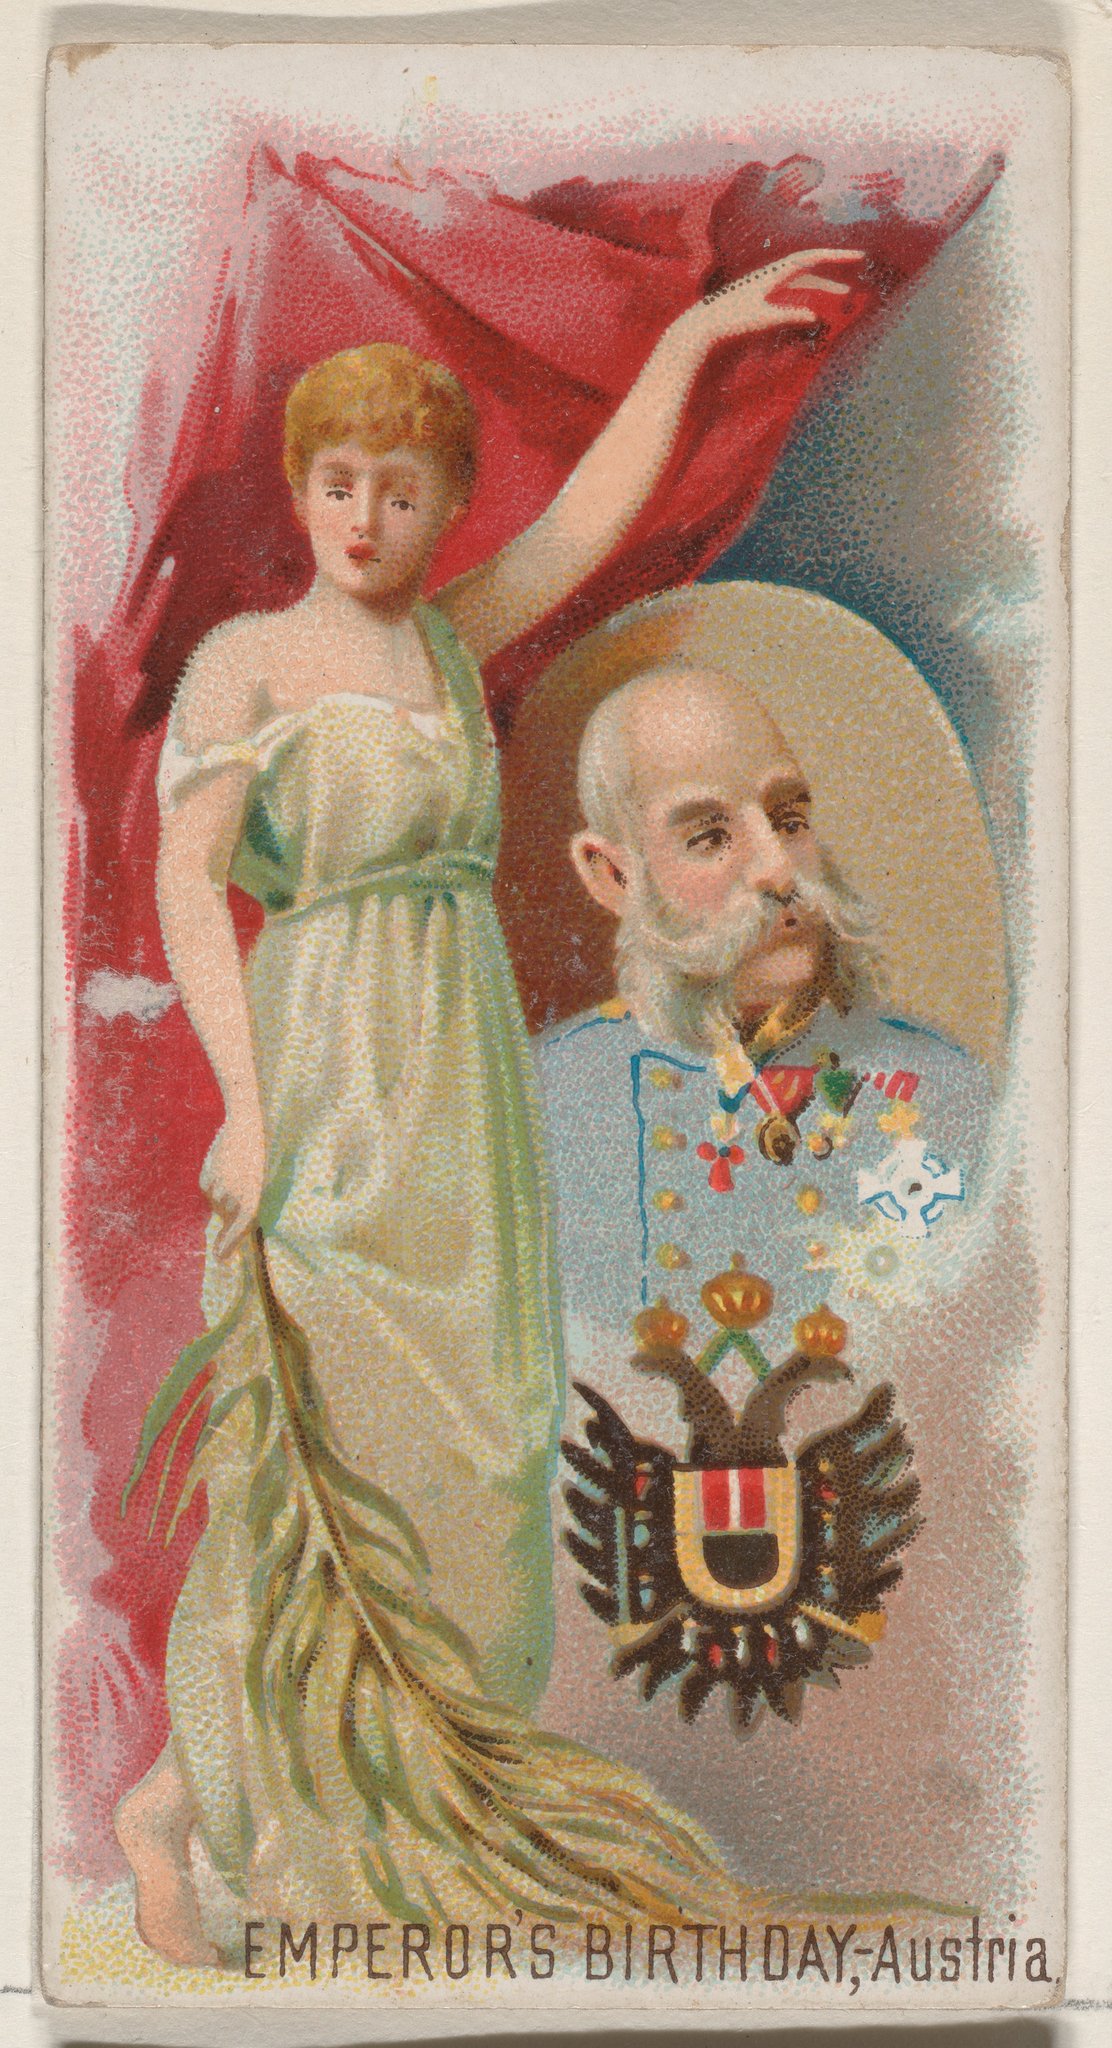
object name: print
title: Emperor's Birthday, Austria, from the Holidays series (N80) for Duke brand cigarettes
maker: w. duke, sons & co.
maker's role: publisher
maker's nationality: american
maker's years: 1870-1920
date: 1890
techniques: color lithograph